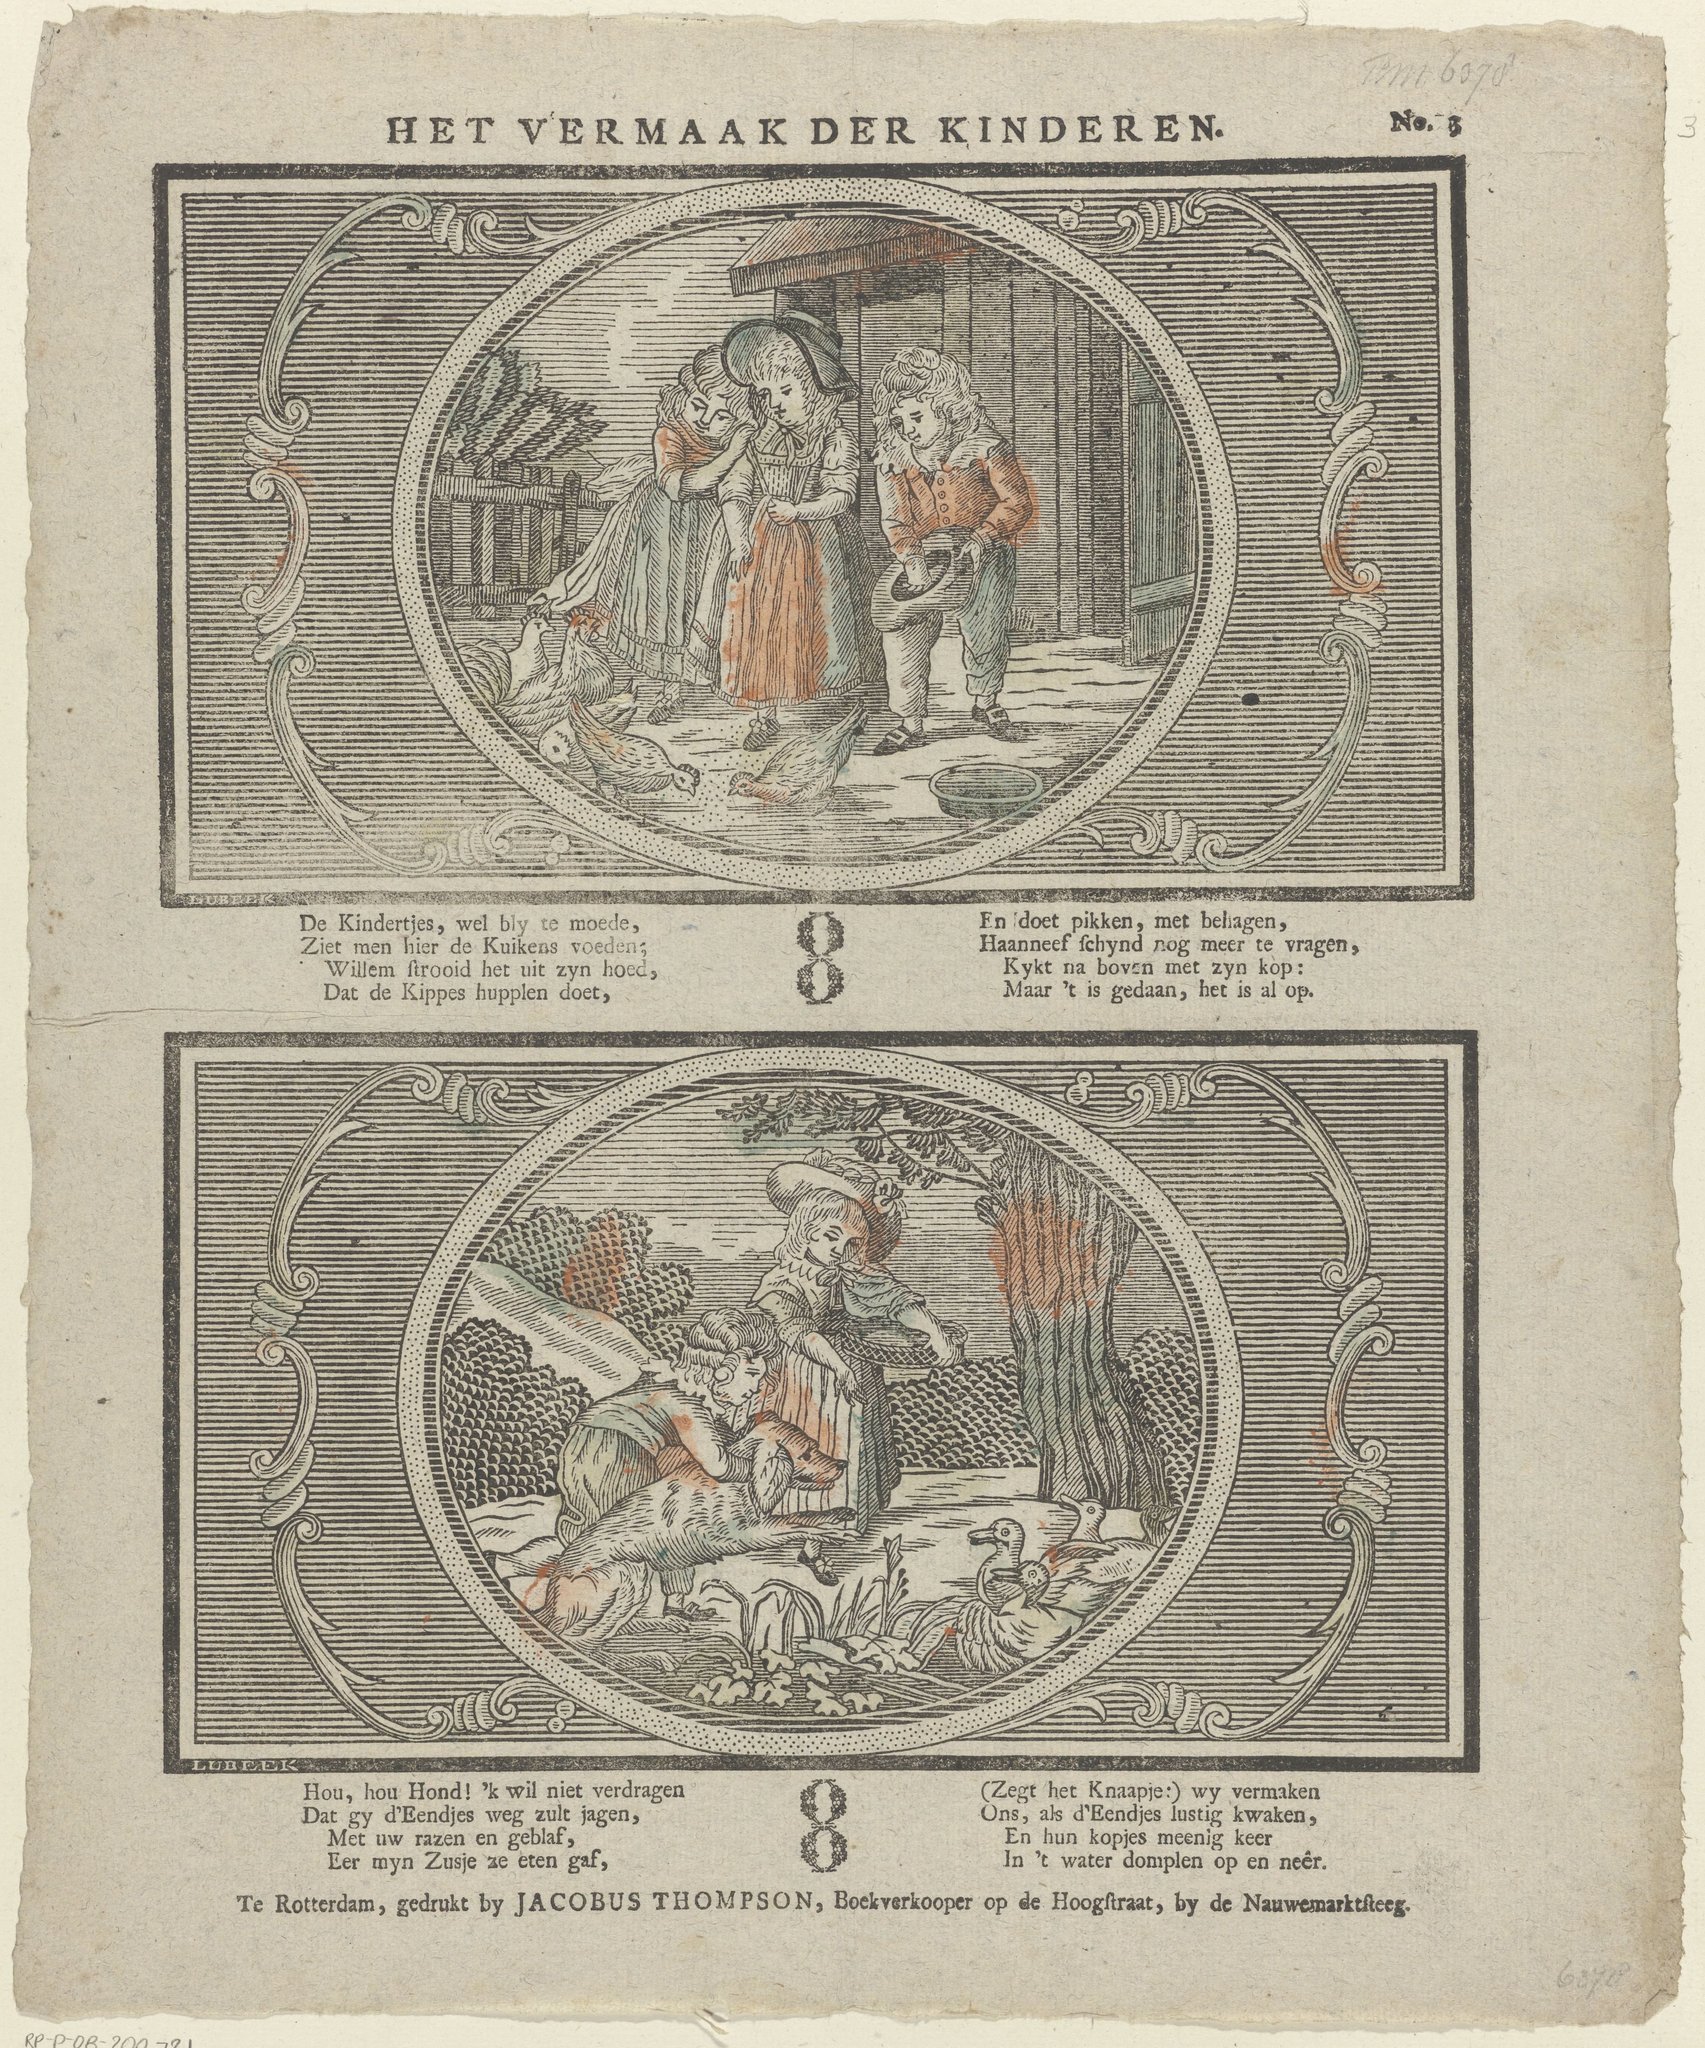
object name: print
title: Het vermaak der kinderen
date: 1791-1812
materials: paper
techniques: colour, letterpress printing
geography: rotterdam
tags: giving food, child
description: Blad met 2 voorstellingen van kindervermaken in sierlijsten. Boven: drie kinderen die kippen voeren. Onder: een meisje dat eendjes voert en een jongen die een hond tegenhoudt de eenden weg te jagen. Onder elke afbeelding een achtregelig vers in twee kolommen. Genummerd rechtsboven: No. 3.